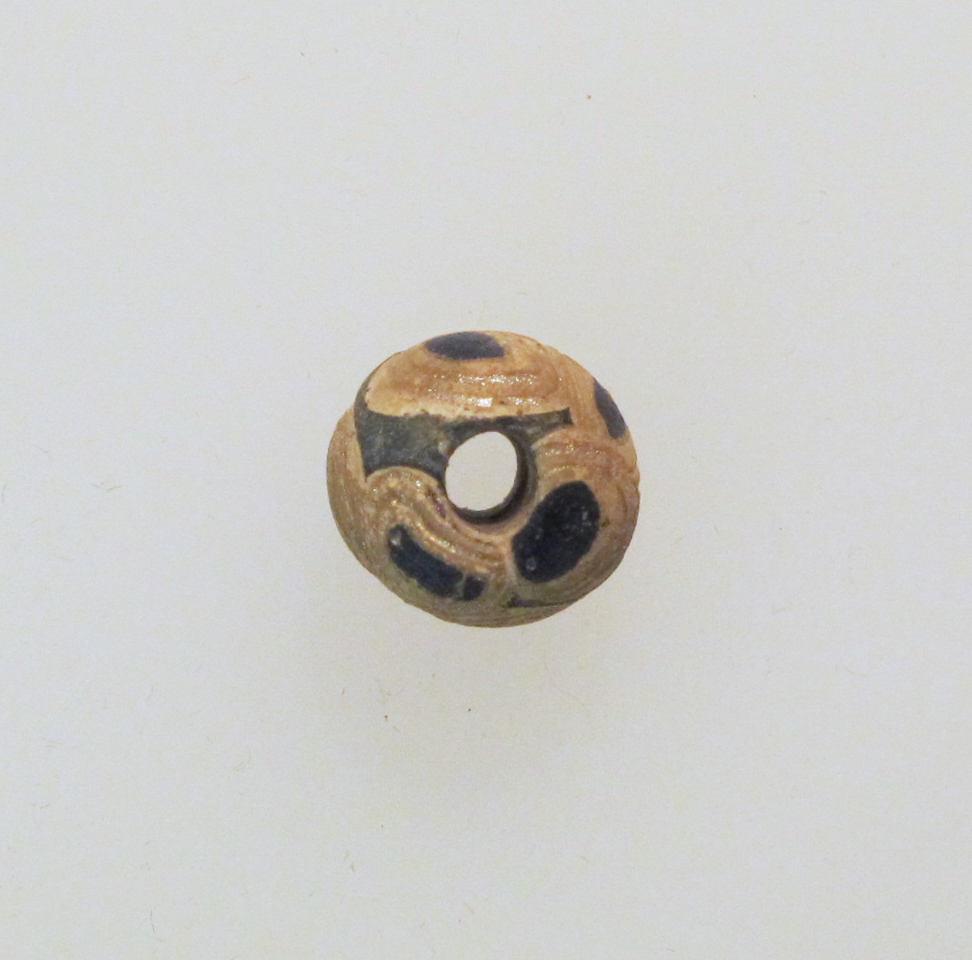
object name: bead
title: Glass eye bead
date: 7000 BCE-330 CE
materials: glass